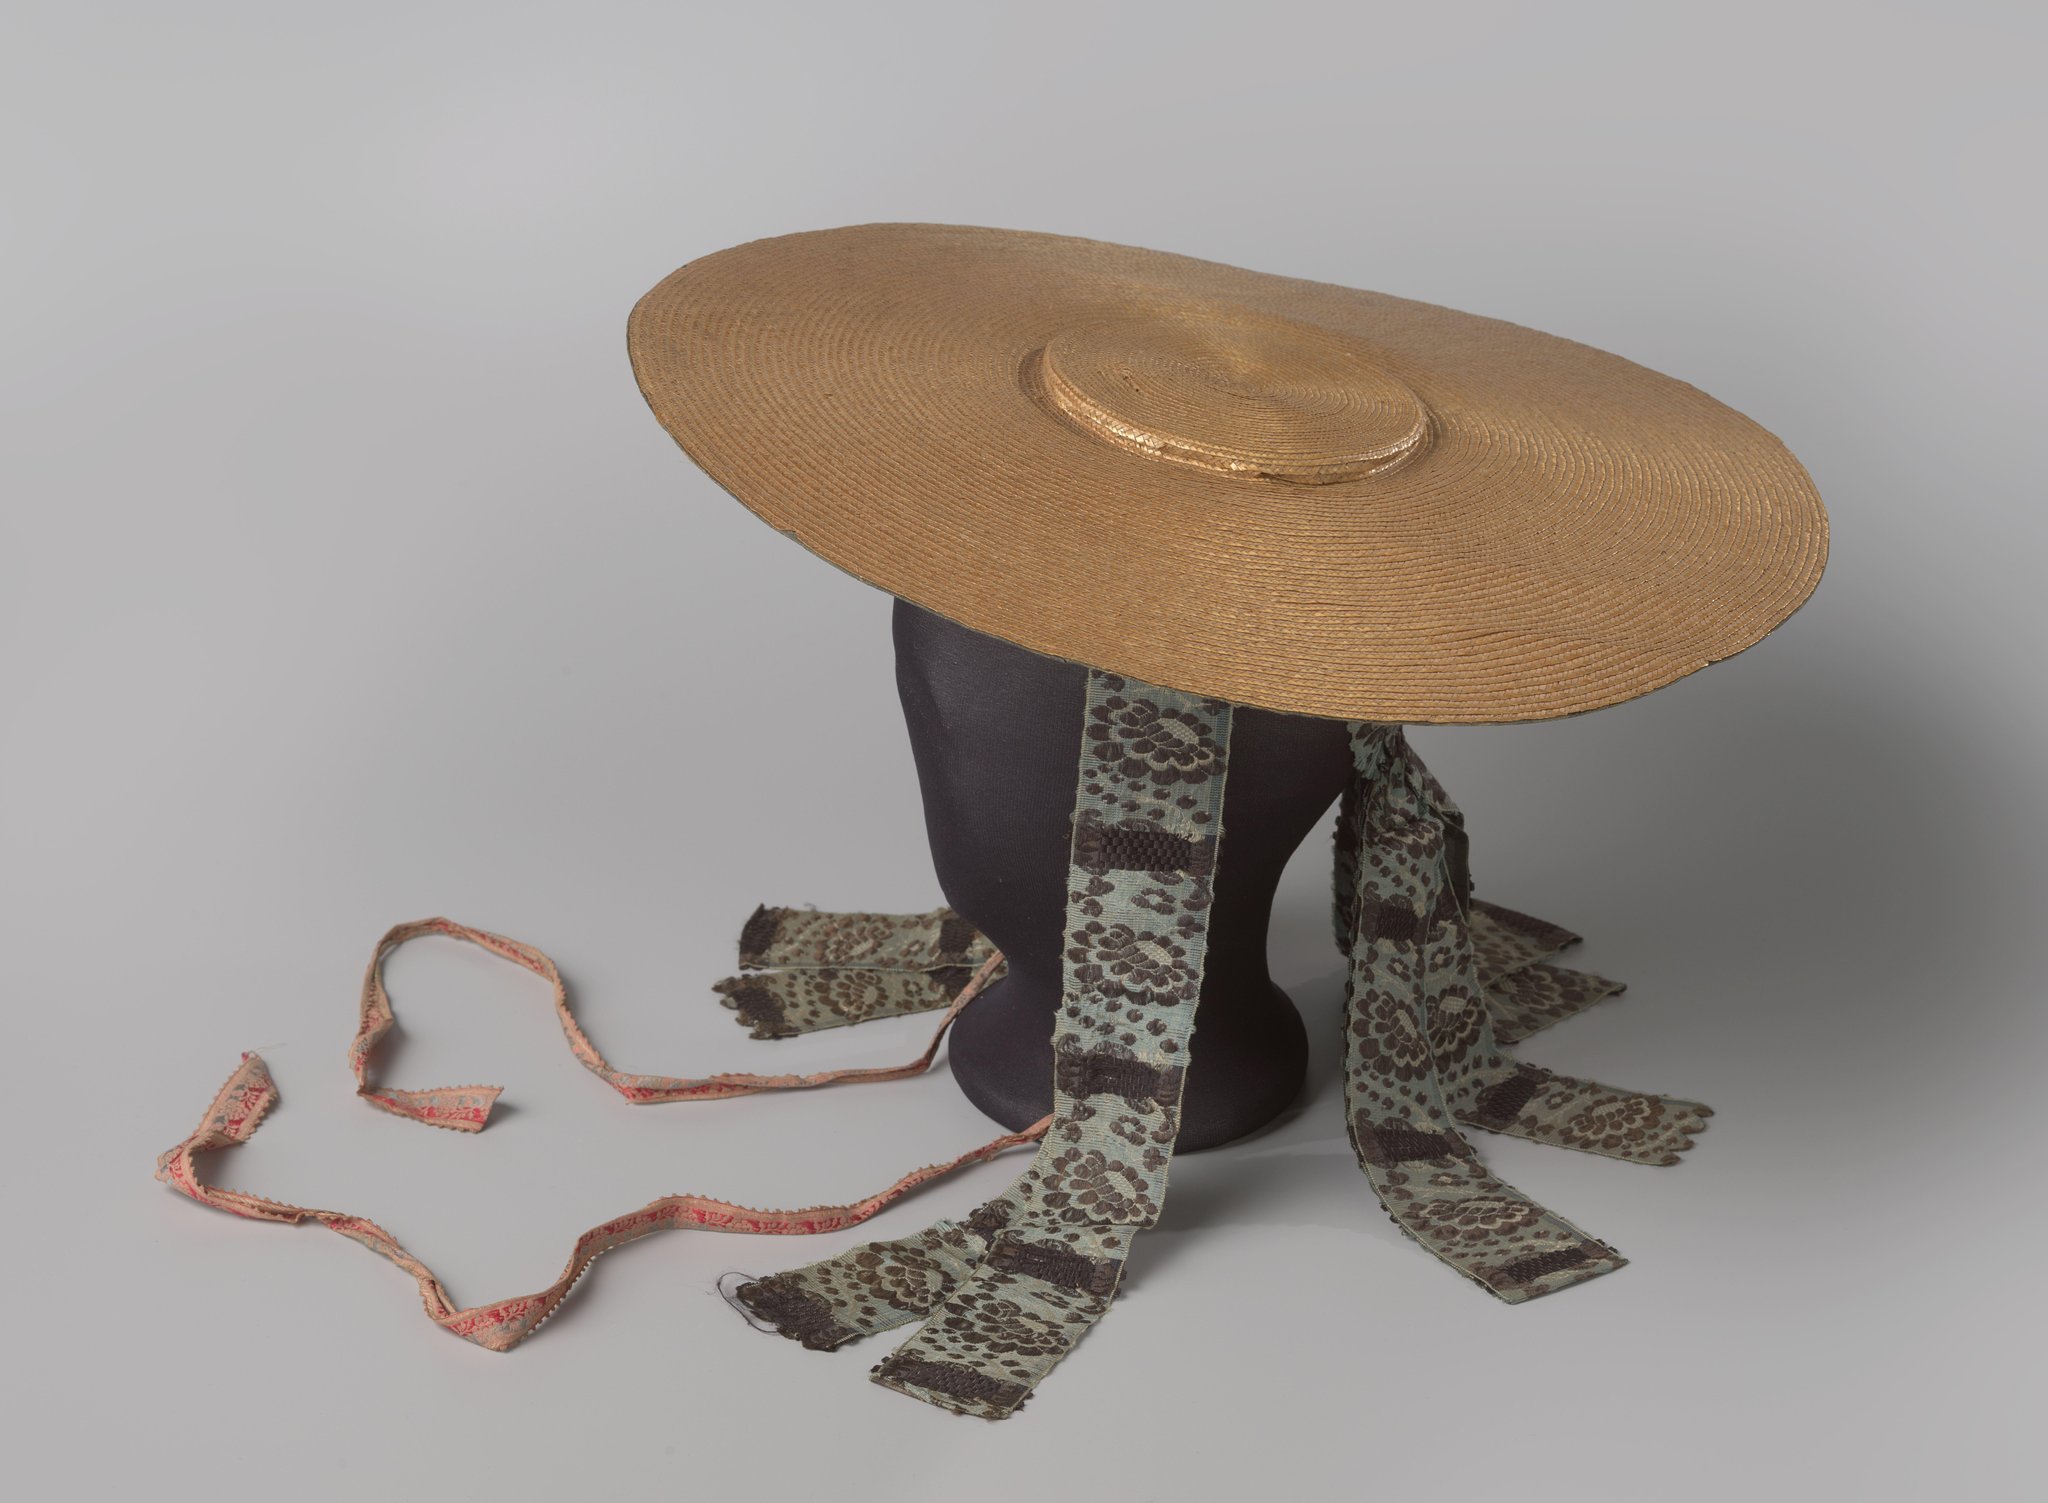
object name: womenswear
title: Zonnehoed, Walcherse dracht (?), van stro, gevoerd met sits, voorzien van zes zijden linten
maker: Anonymous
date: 1735-1765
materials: textile, cotton, silk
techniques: braiding, printing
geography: netherlands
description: onnehoed, Walcherse dracht (?), of Remlandelijke mode van "herderinne-hoed"of "melkmeisjes hoed". Model: zeer platte bol en vlakke brede rand. Materiaal: naturel stroo, gevoerd over de gehele onderzijde met echte sits en nog voorzien van zes zijden linten. Voering: de sits heeft een witte ondergrond en een vol patroon van fijne bloemrankjes in rood, blauw, paars en schaars geel. Linten: vier brede zijden linten met hanekammenpuntjes vertonen een lichtblauwe ondergrond met een zwart bloempatroon tussen dwars strepen. Twee hiervan zijn loshangende zijlinten, halverwege verdubbeld, twee zijn onder der wrong gesloten achterlinten met lange lussen en einden. Halverwege de zijlinden zijn twee lange smalle rose lintjes aangenaaid met rood en bleu bloemdessin, om de hoed in de vereiste stand te houden.